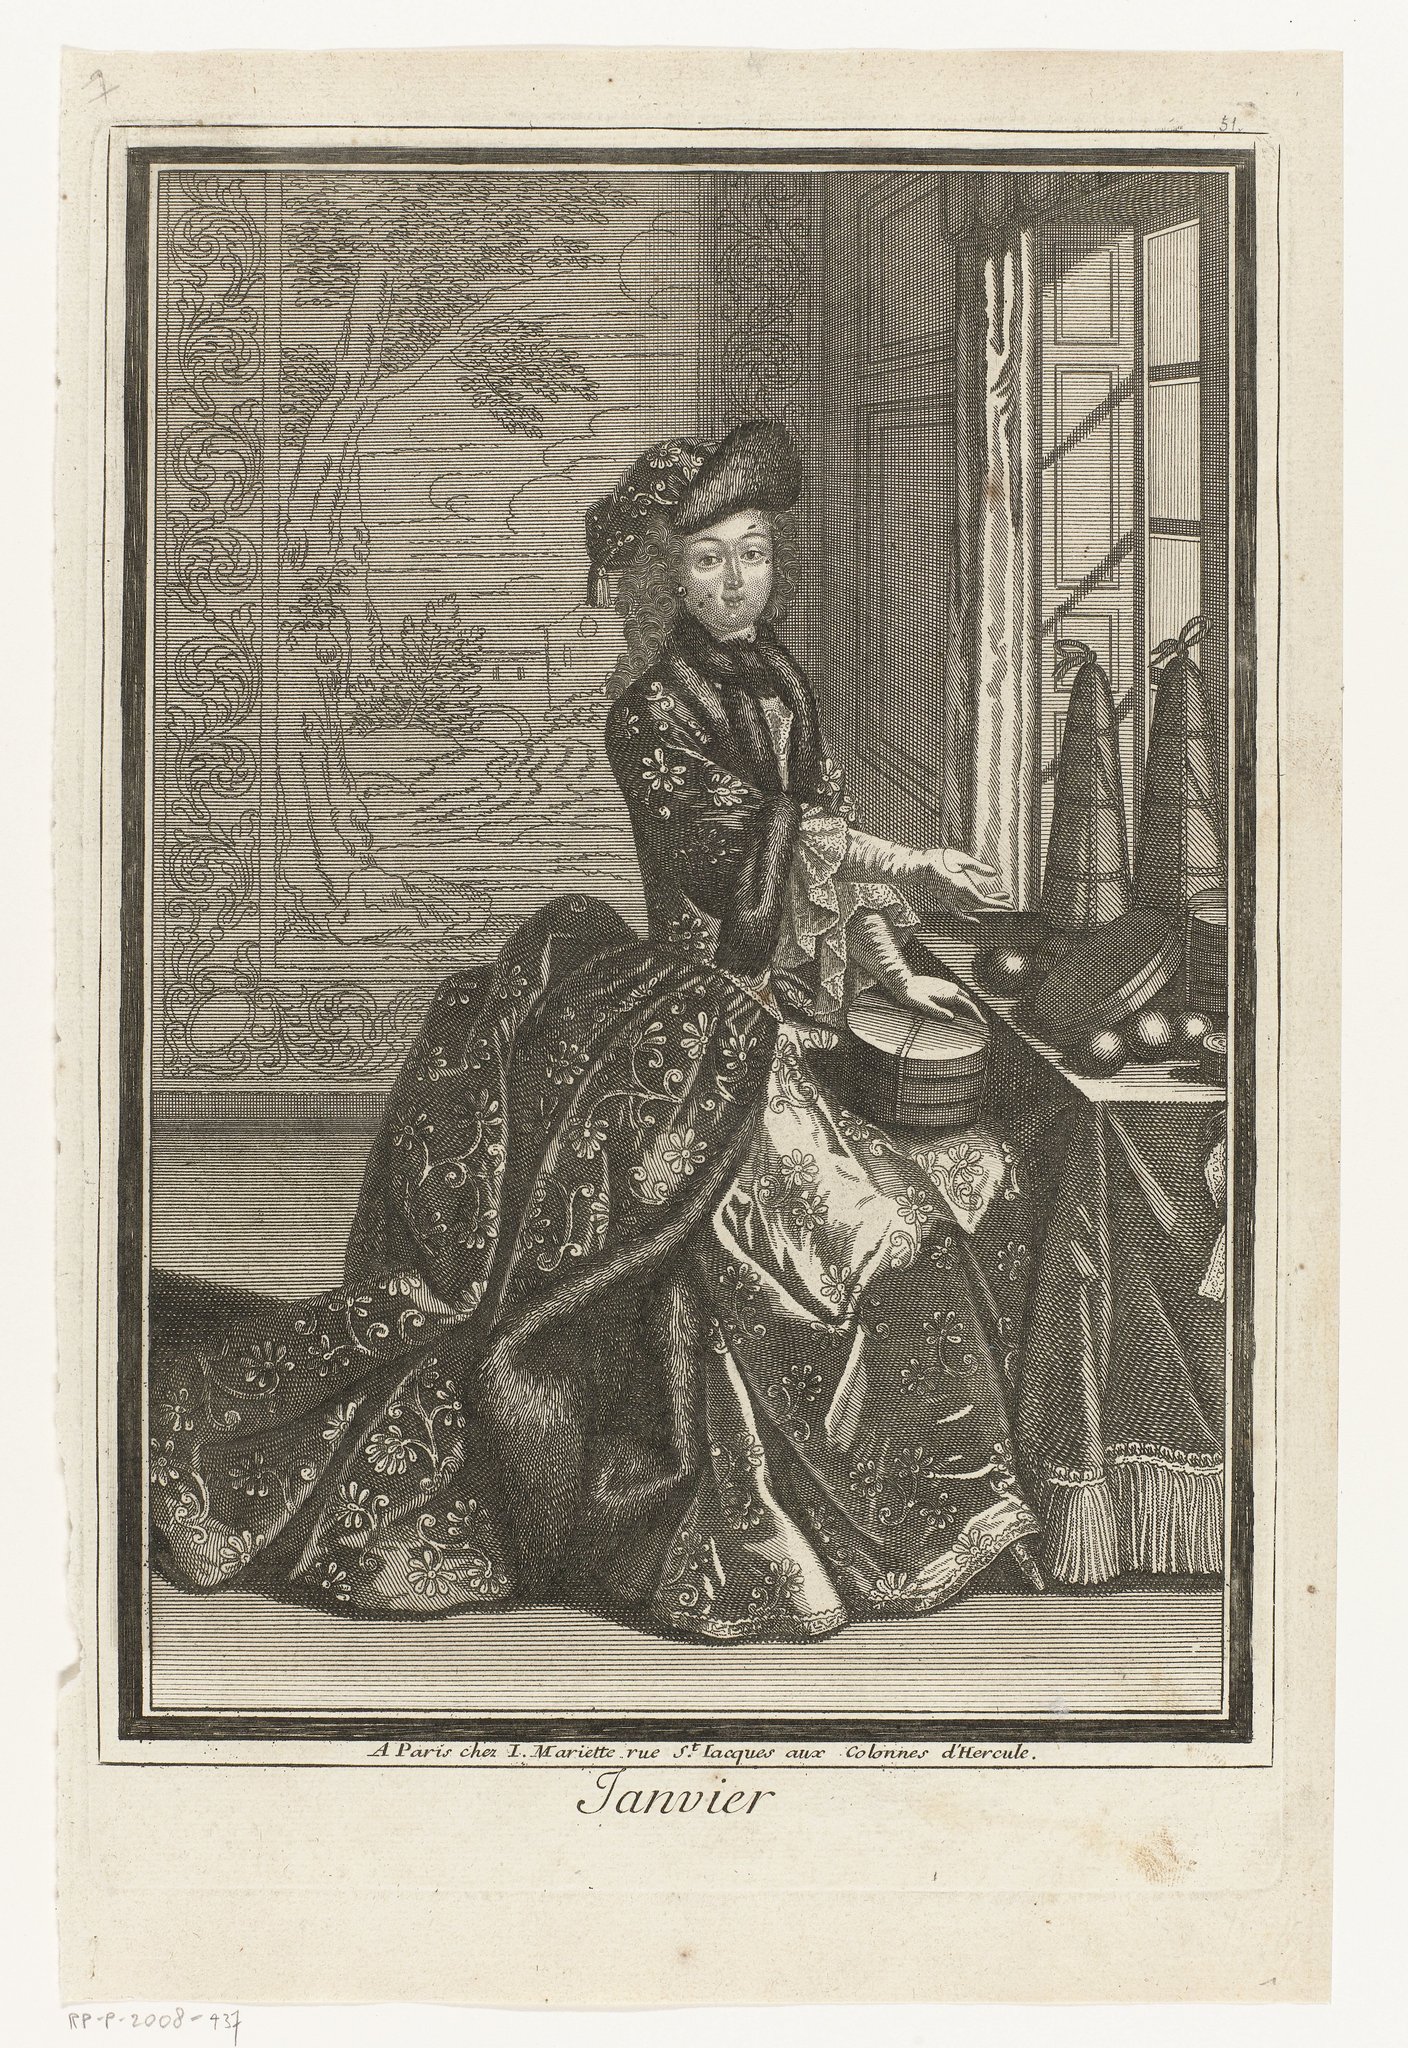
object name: print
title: Janvier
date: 1670-1742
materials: paper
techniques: engraving, etching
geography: paris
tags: the twelve months (especially personifications); 'mese in generale' (ripa), tapestry, january; 'gennaro' (ripa)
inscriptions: collector's mark: Lugt 2760, collector's mark: Lugt 2228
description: Maakt deel uit van een twaalfdelige serie met personificaties van de twaalf maanden. Mogelijk betreft de prentmaker een lid van de familie Bonnart.